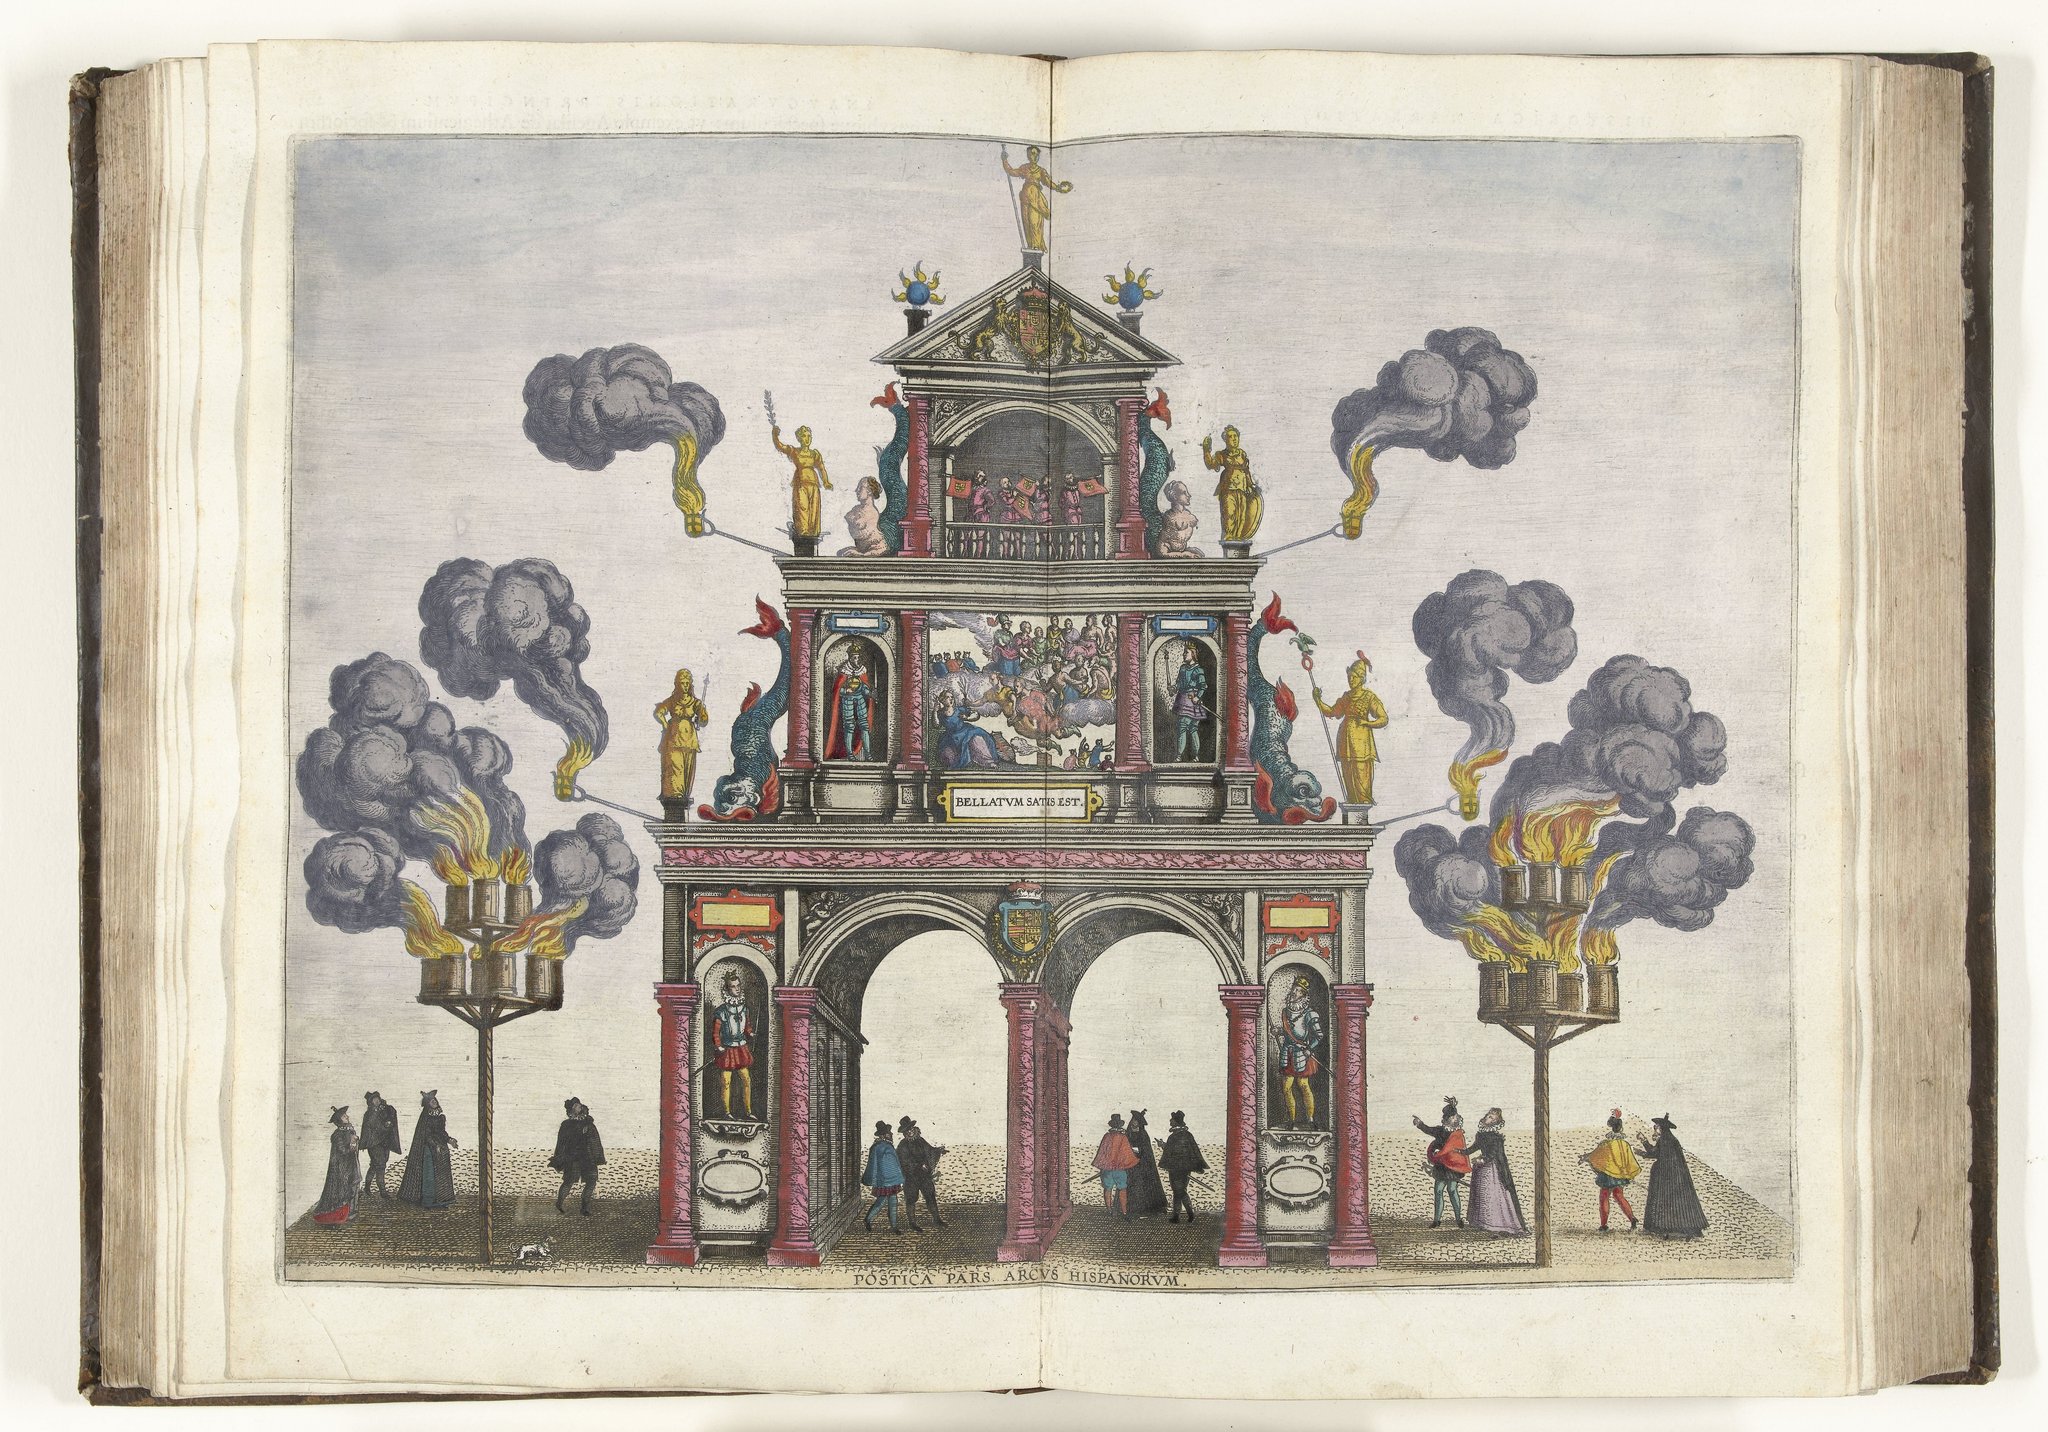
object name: print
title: Postica pars arcus Hispanorum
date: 1599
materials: paper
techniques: etching, hand coloring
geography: antwerp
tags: infante van spanje isabella clara eugenia, brussels, albrecht aartshertog van oostenrijk, triumphal arch, triumphal entry and public reception, pageant, 'entrée solennelle', 'joyeuse entrée', antwerp, spain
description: De Spaanse erepoort (voorzijde), december 1599. Triomfpoort versierd met een allegorische voorstelling van het einde van de oorlog en het verbond tussen Spanje en de Zuidelijke Nederlanden. Bovenin muzikanten, links en rechts palen met brandende pektonnen. Tijdens de intocht te Antwerpen opgesteld in de Lange Gasthuisstraat en de Arembergstraat. Onderdeel van: Historica narratio profectionis et inaugurationis serenissimorum Belgii principum Alberti et Isabellae Austriae archiducum, de beschrijving van de intochten van het paar te Brussel, Antwerpen, Gent en Valenciennes, 1599.